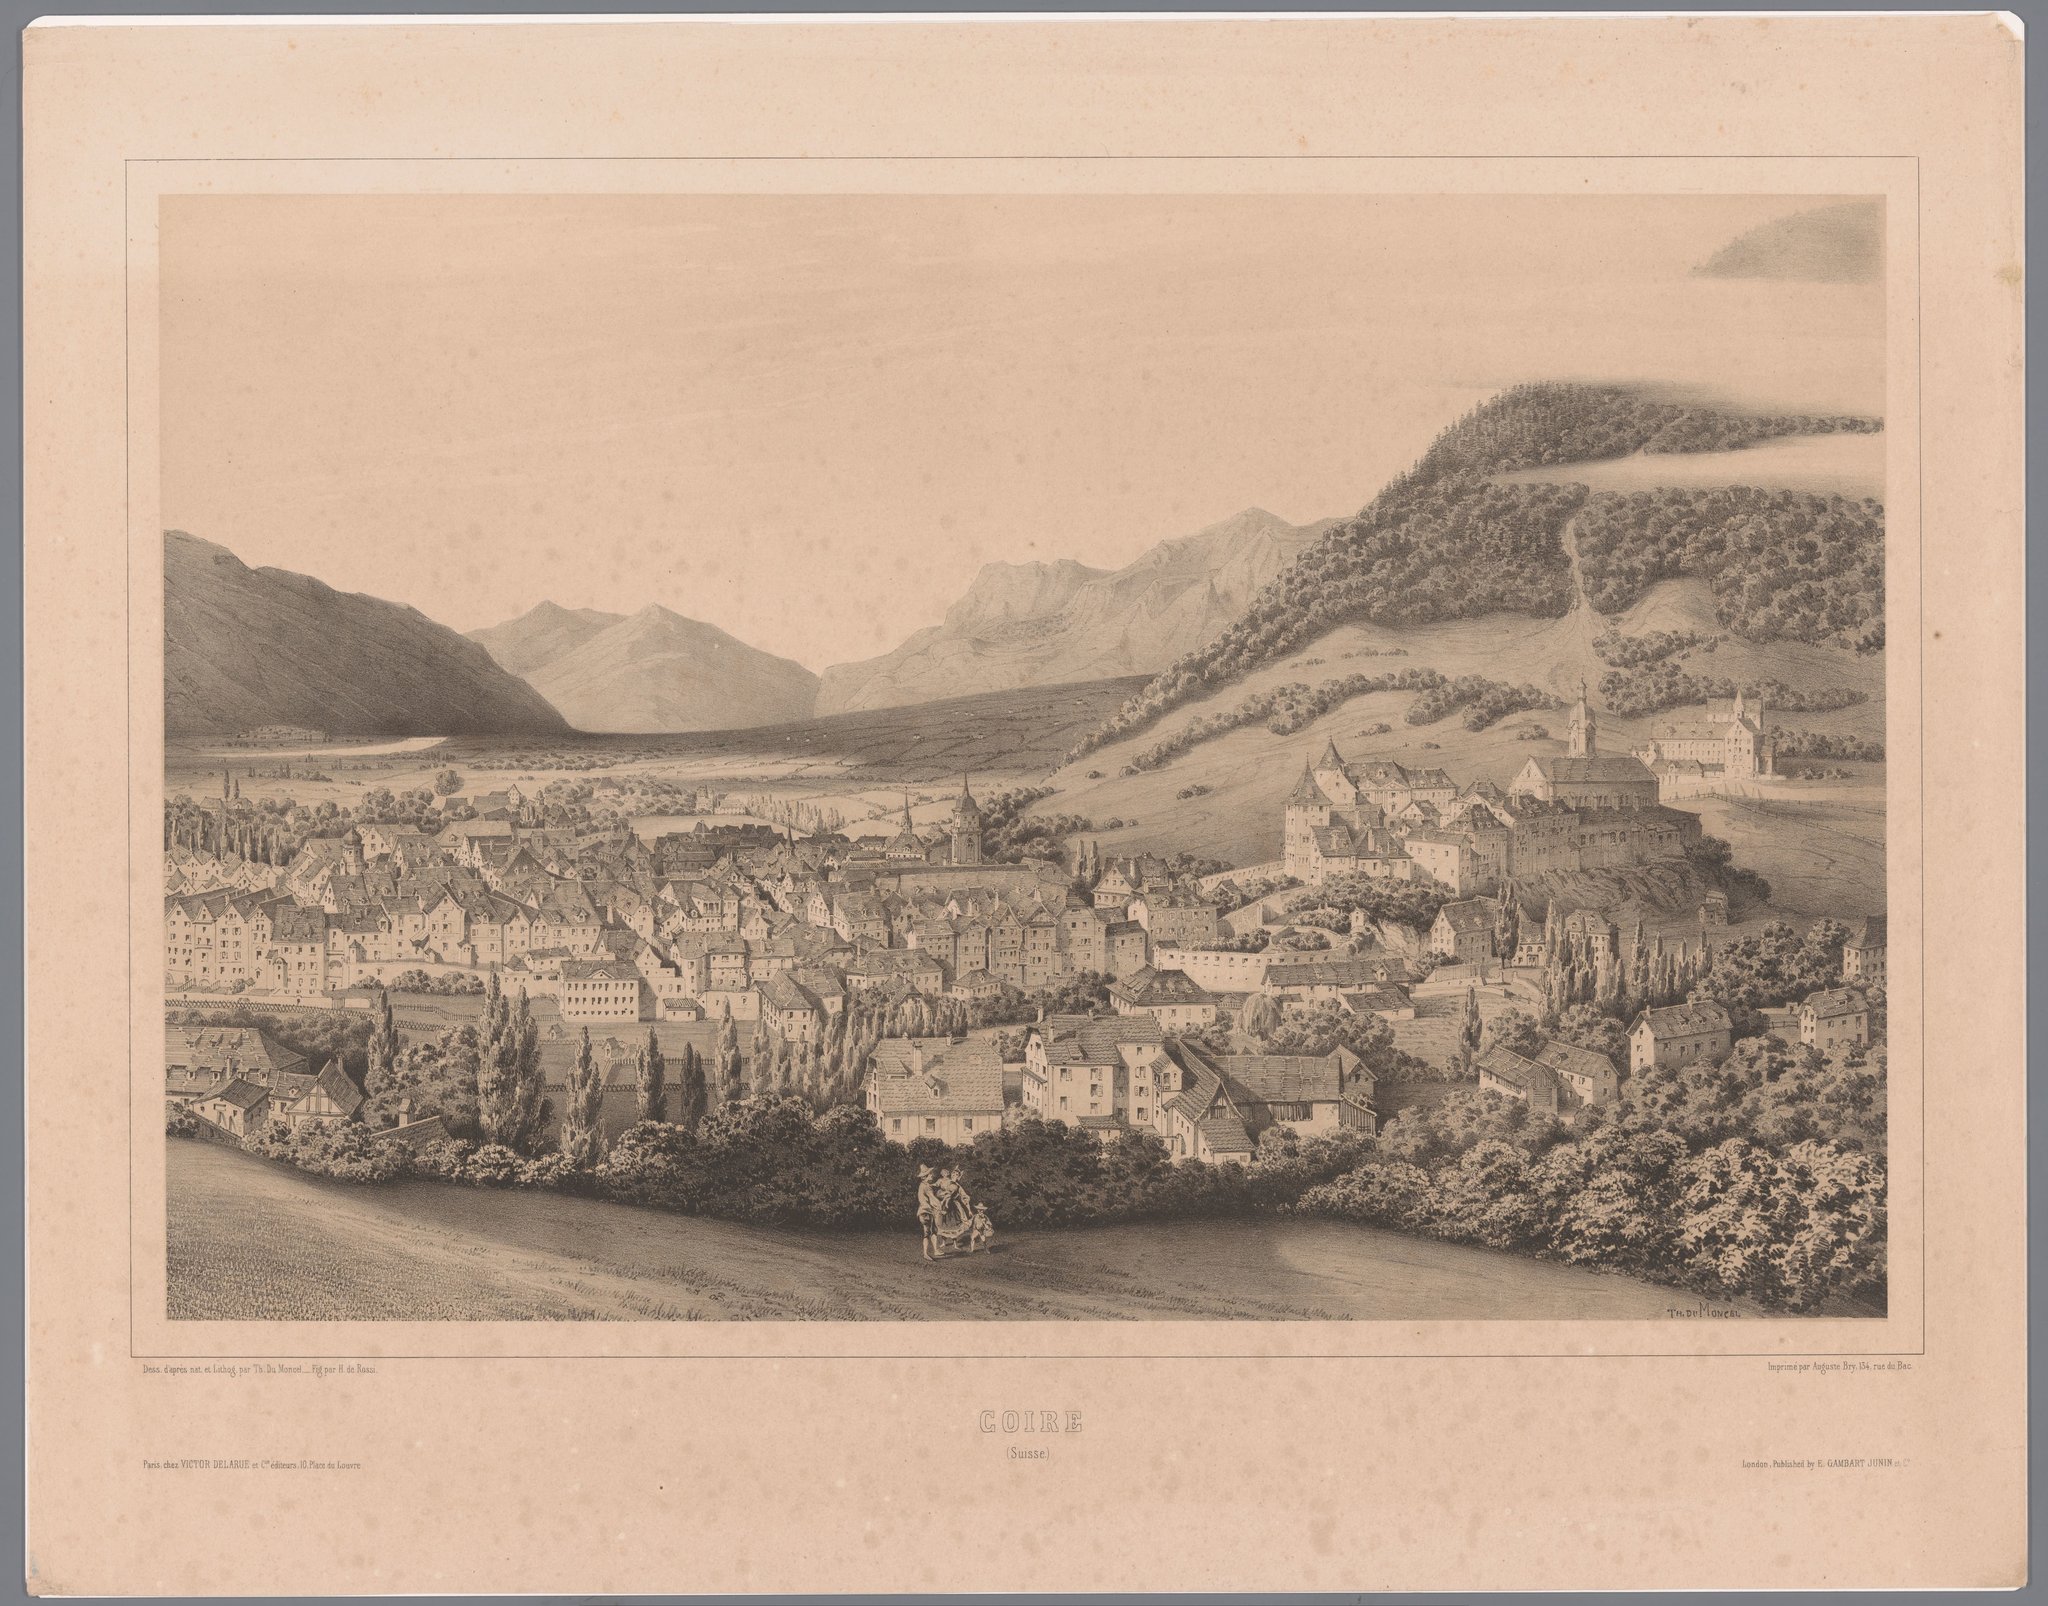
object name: print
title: Coire (Suisse)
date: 1847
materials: paper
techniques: lithograph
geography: london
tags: mountains (+ landscape with figures, staffage), city-view in general; 'veduta' (+ city(-scape) with figures, staffage)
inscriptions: check stamp: Lugt 4011, collector's mark: Lugt 2228a